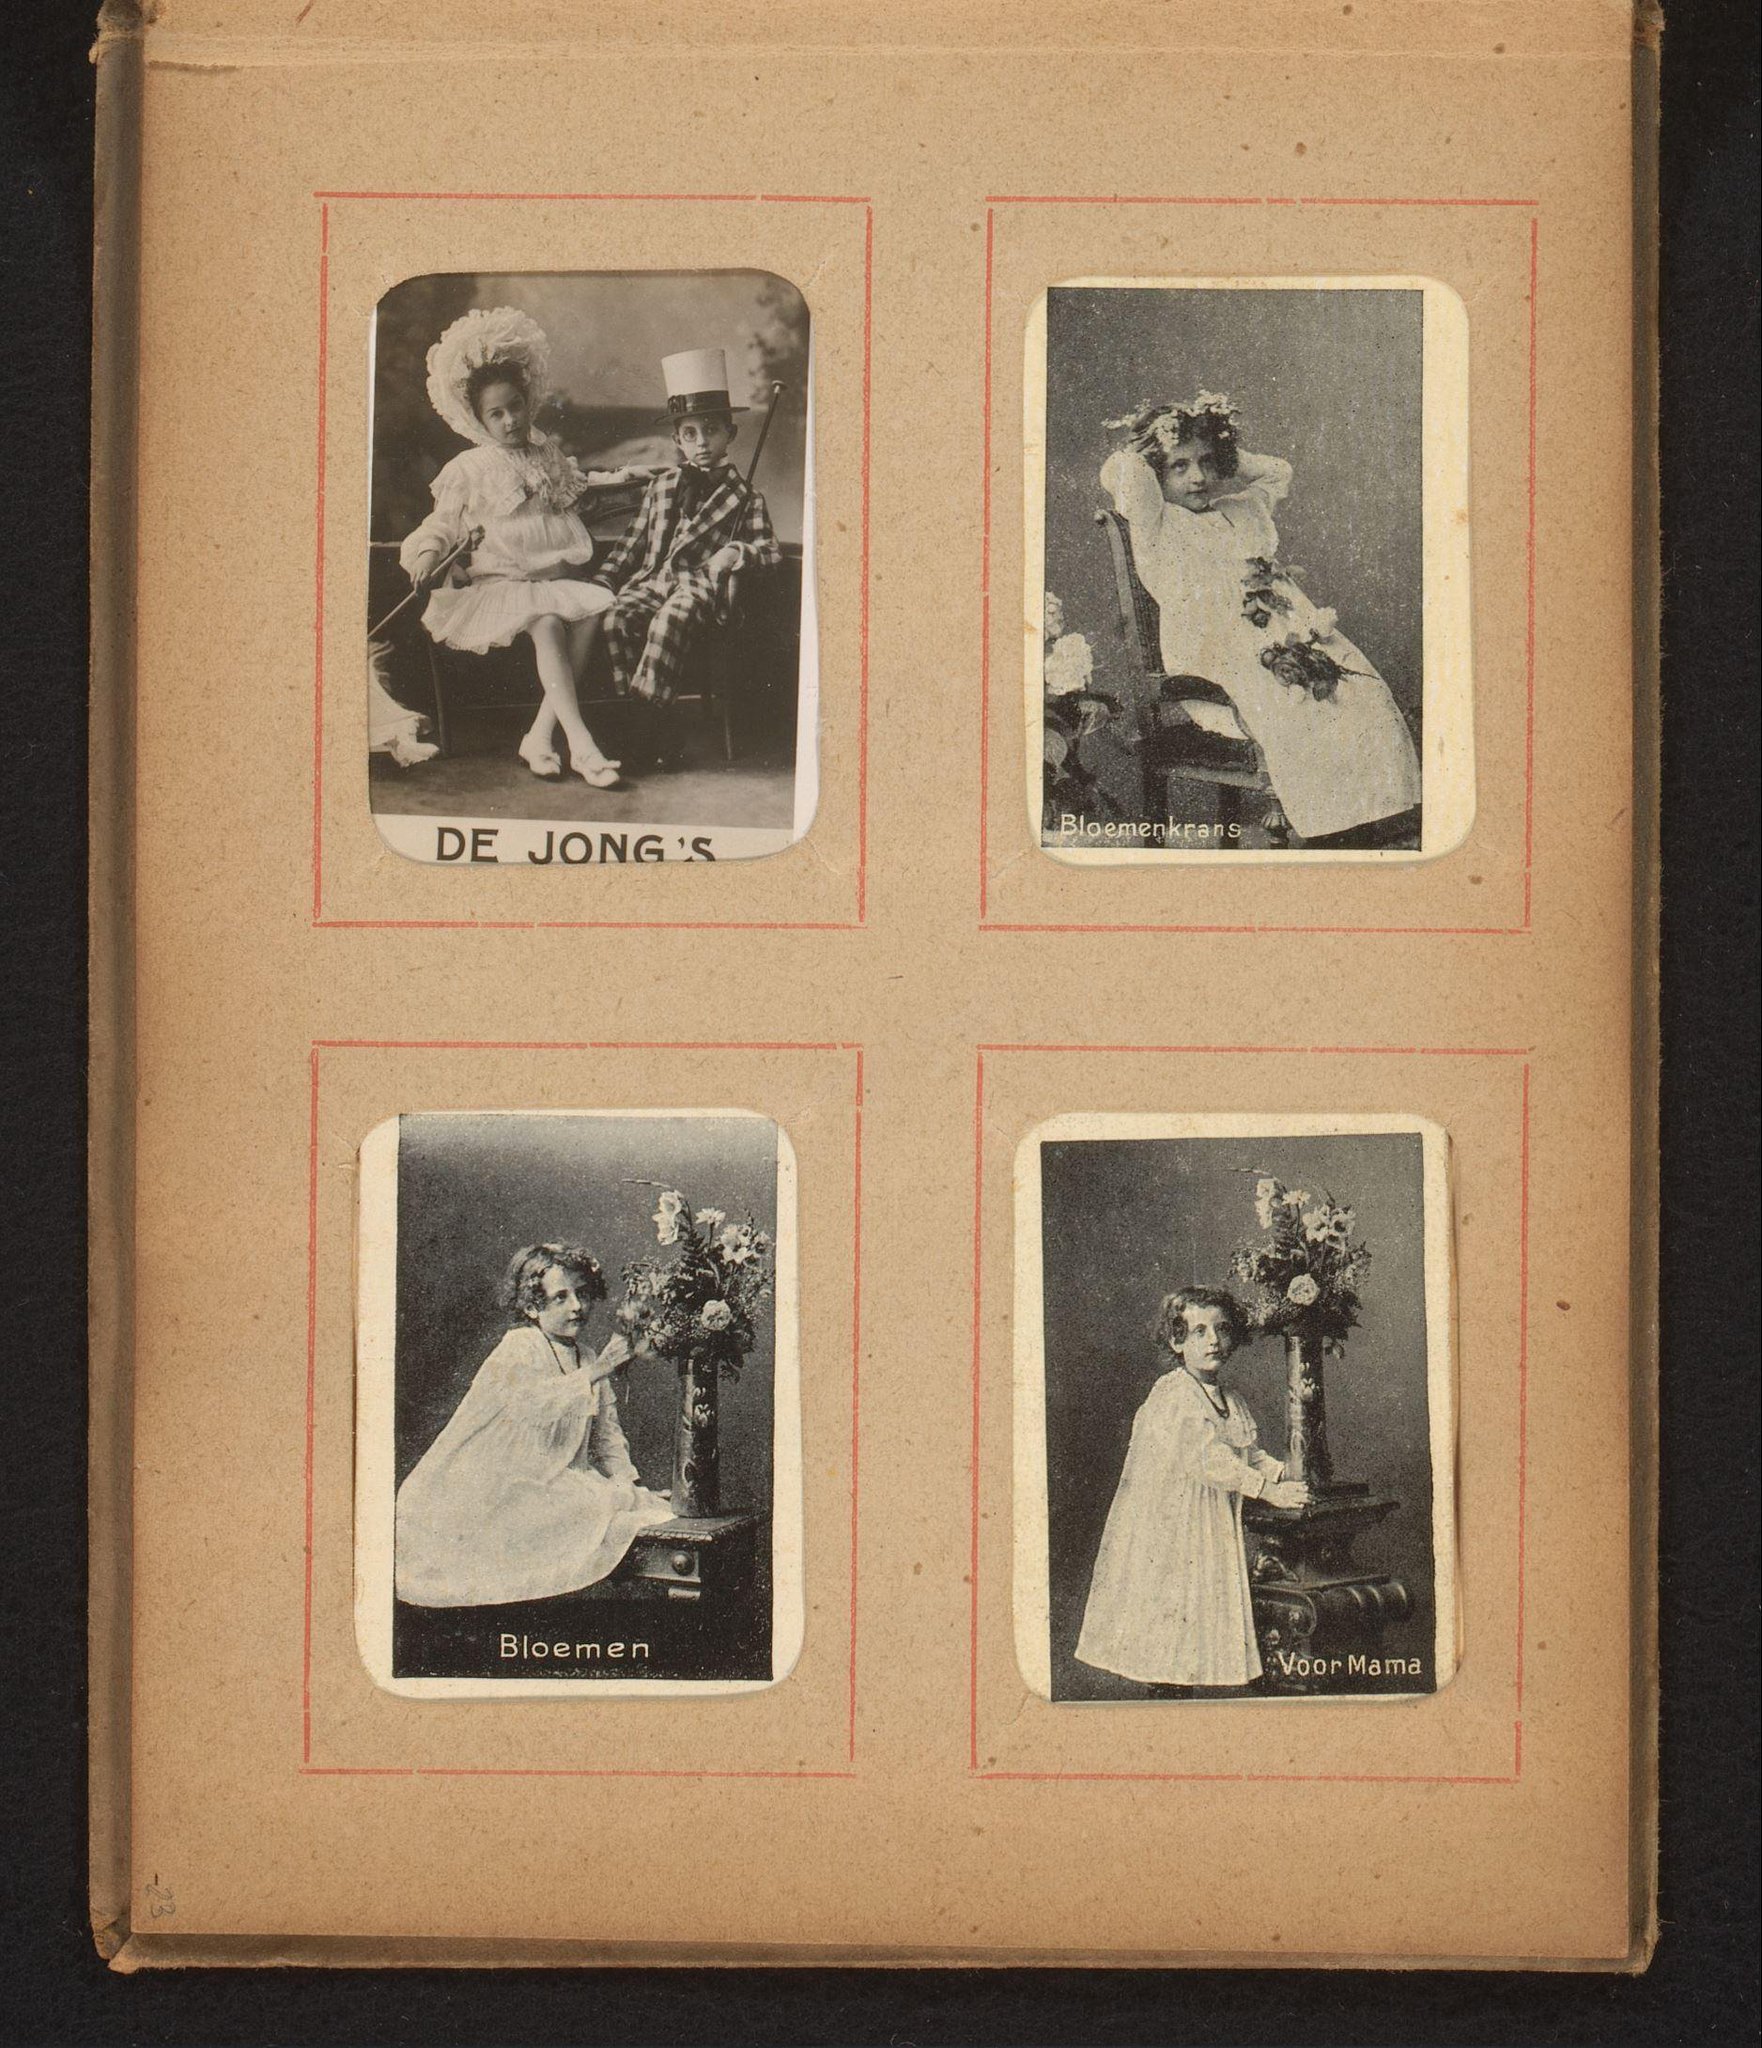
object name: photomechanical print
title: Kinderportretten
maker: Anonymous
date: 1880-1920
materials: paper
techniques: autotype, gelatin silver print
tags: flowers, child, trade games, imitative games, imitating adults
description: Een portret van een jongen en meisje in verkleedkleding en drie portretten van een meisje met bloemen. De portretten hebben op de voorzijde opschriften; De Jong's, Bloemenkrans, Bloemen en Voor mama. Deze pagina maakt deel uit van een album.